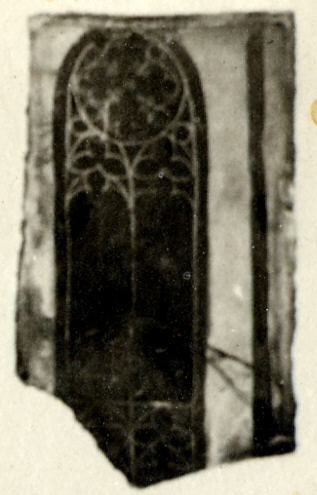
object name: fragment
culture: french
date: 1401-1500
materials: glass, paint, silver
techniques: stain